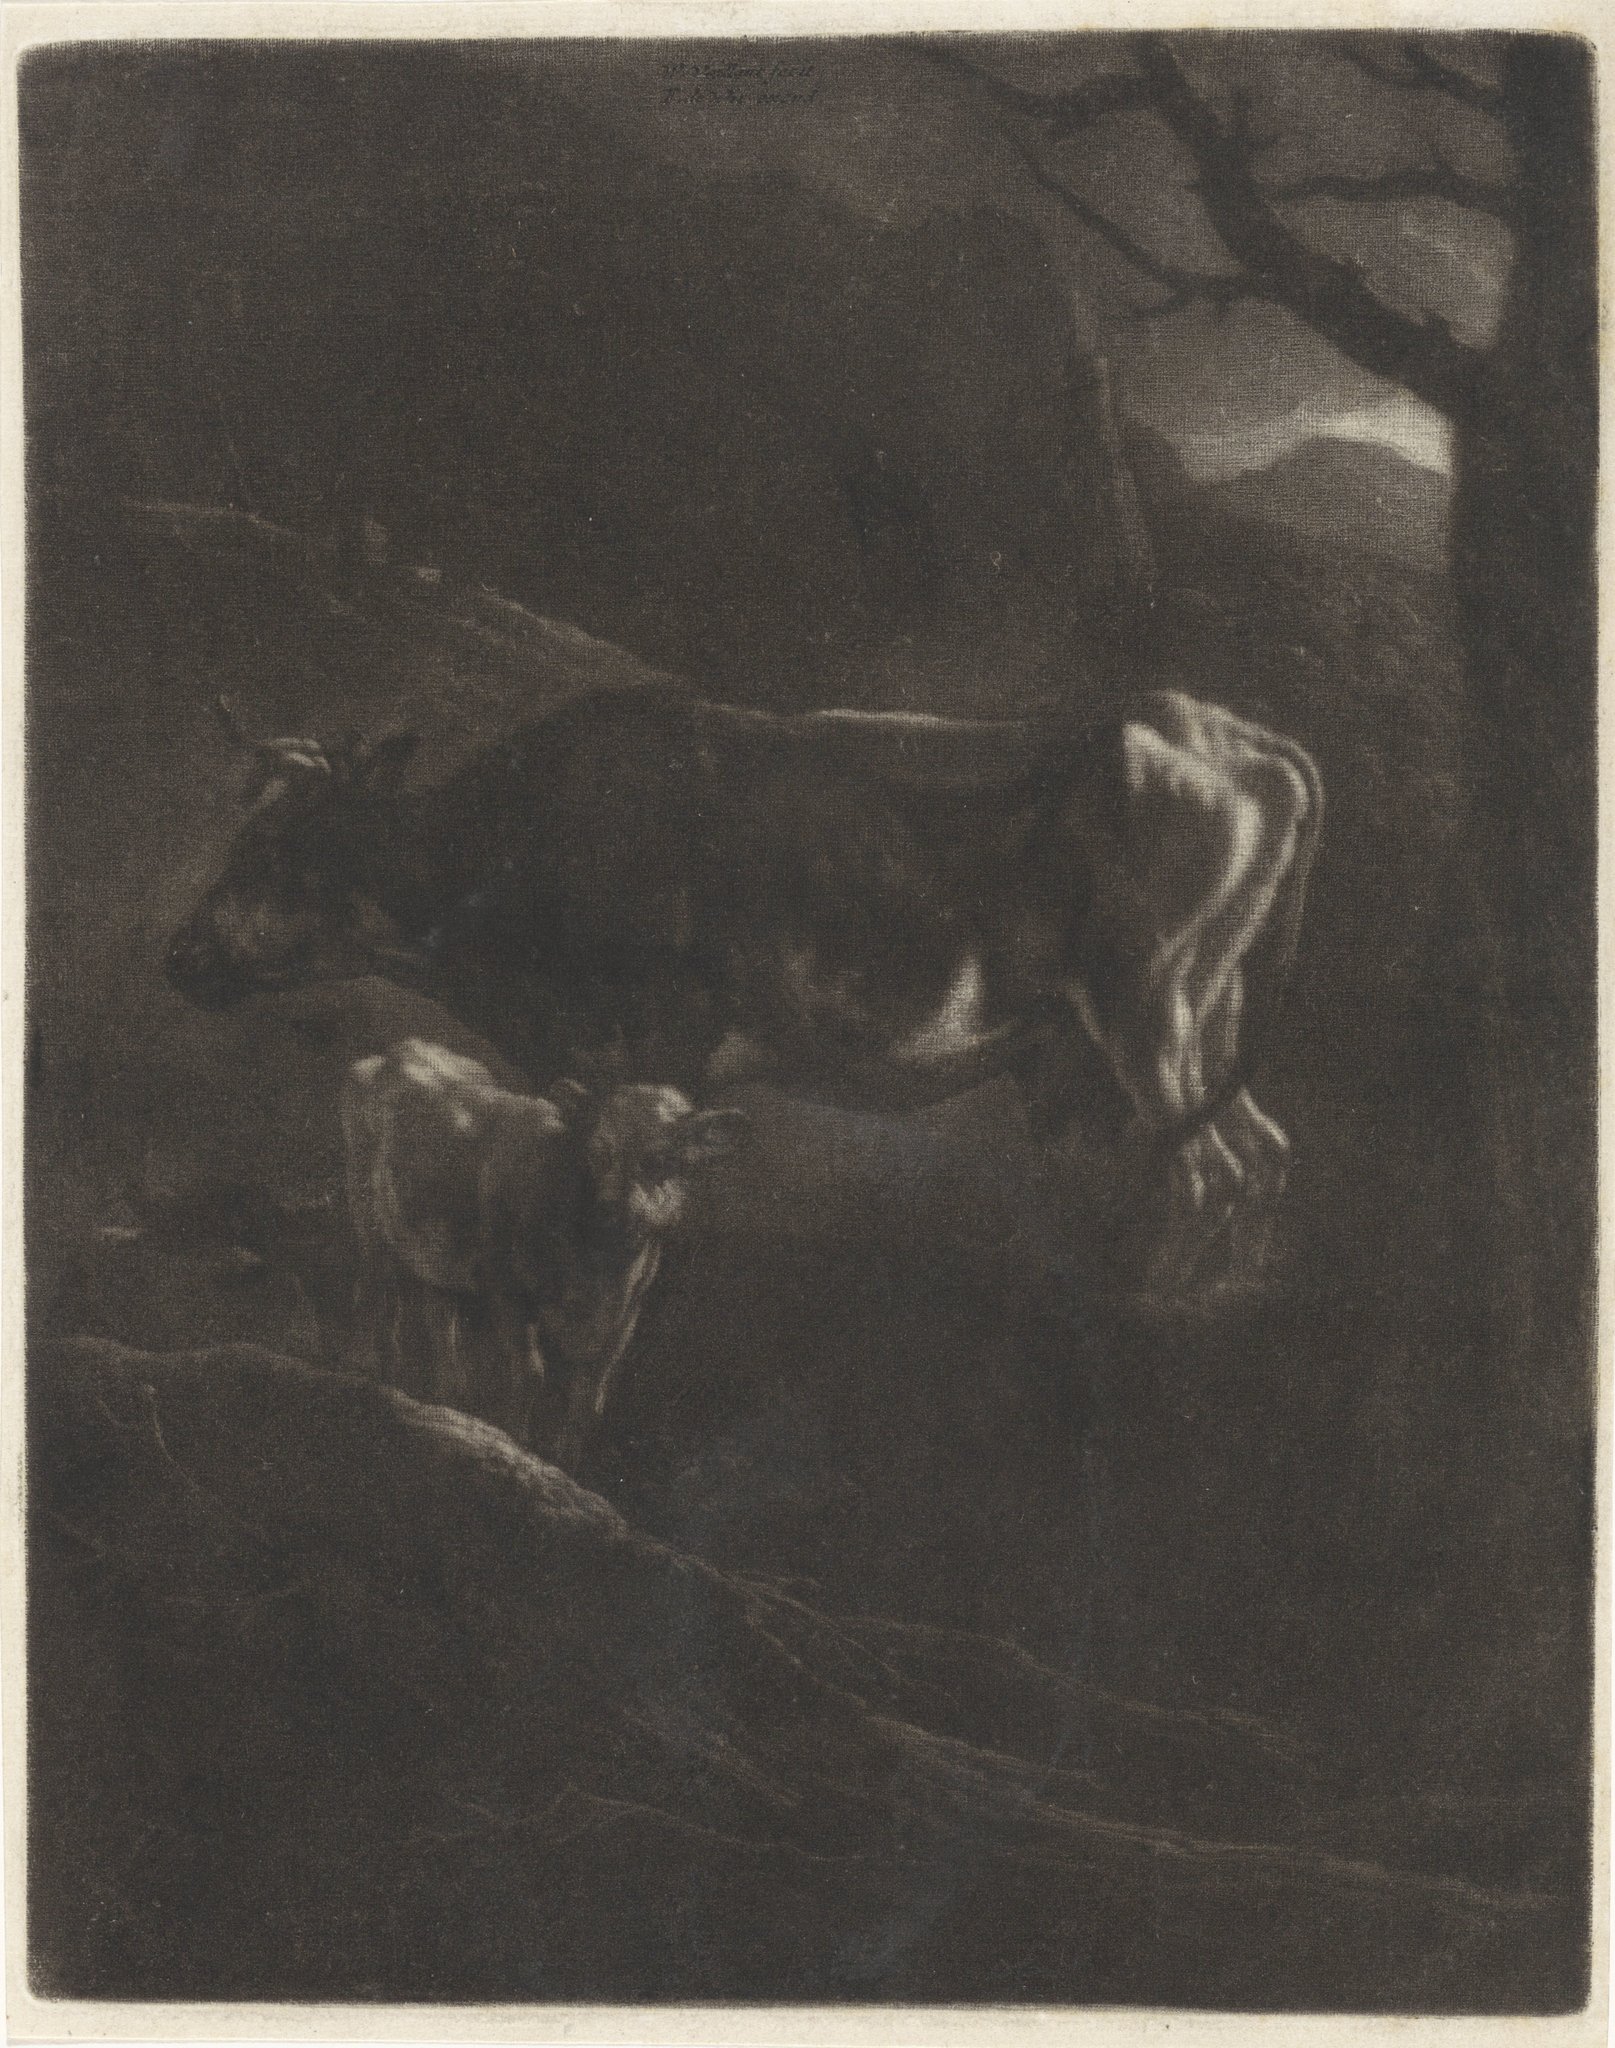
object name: print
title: Avondlandschap met een koe en een kalf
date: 1658-1706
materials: paper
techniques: mezzotint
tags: cow, night ~ landscape (sometimes titled 'nox')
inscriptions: collector's mark: Lugt 2228, collector's mark: Lugt 567